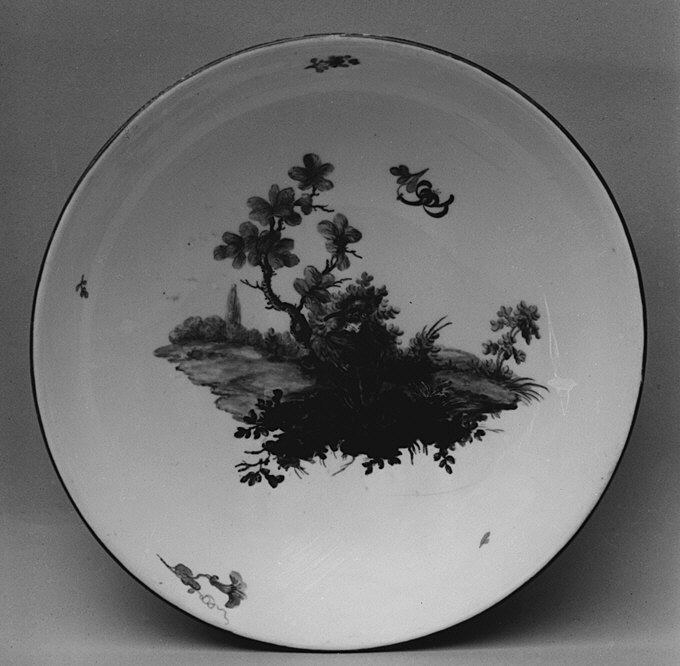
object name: saucer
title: Saucer (part of a service)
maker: frankenthal porcelain manufactory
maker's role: manufactory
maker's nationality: german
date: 1770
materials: hard paste porcelain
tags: plants